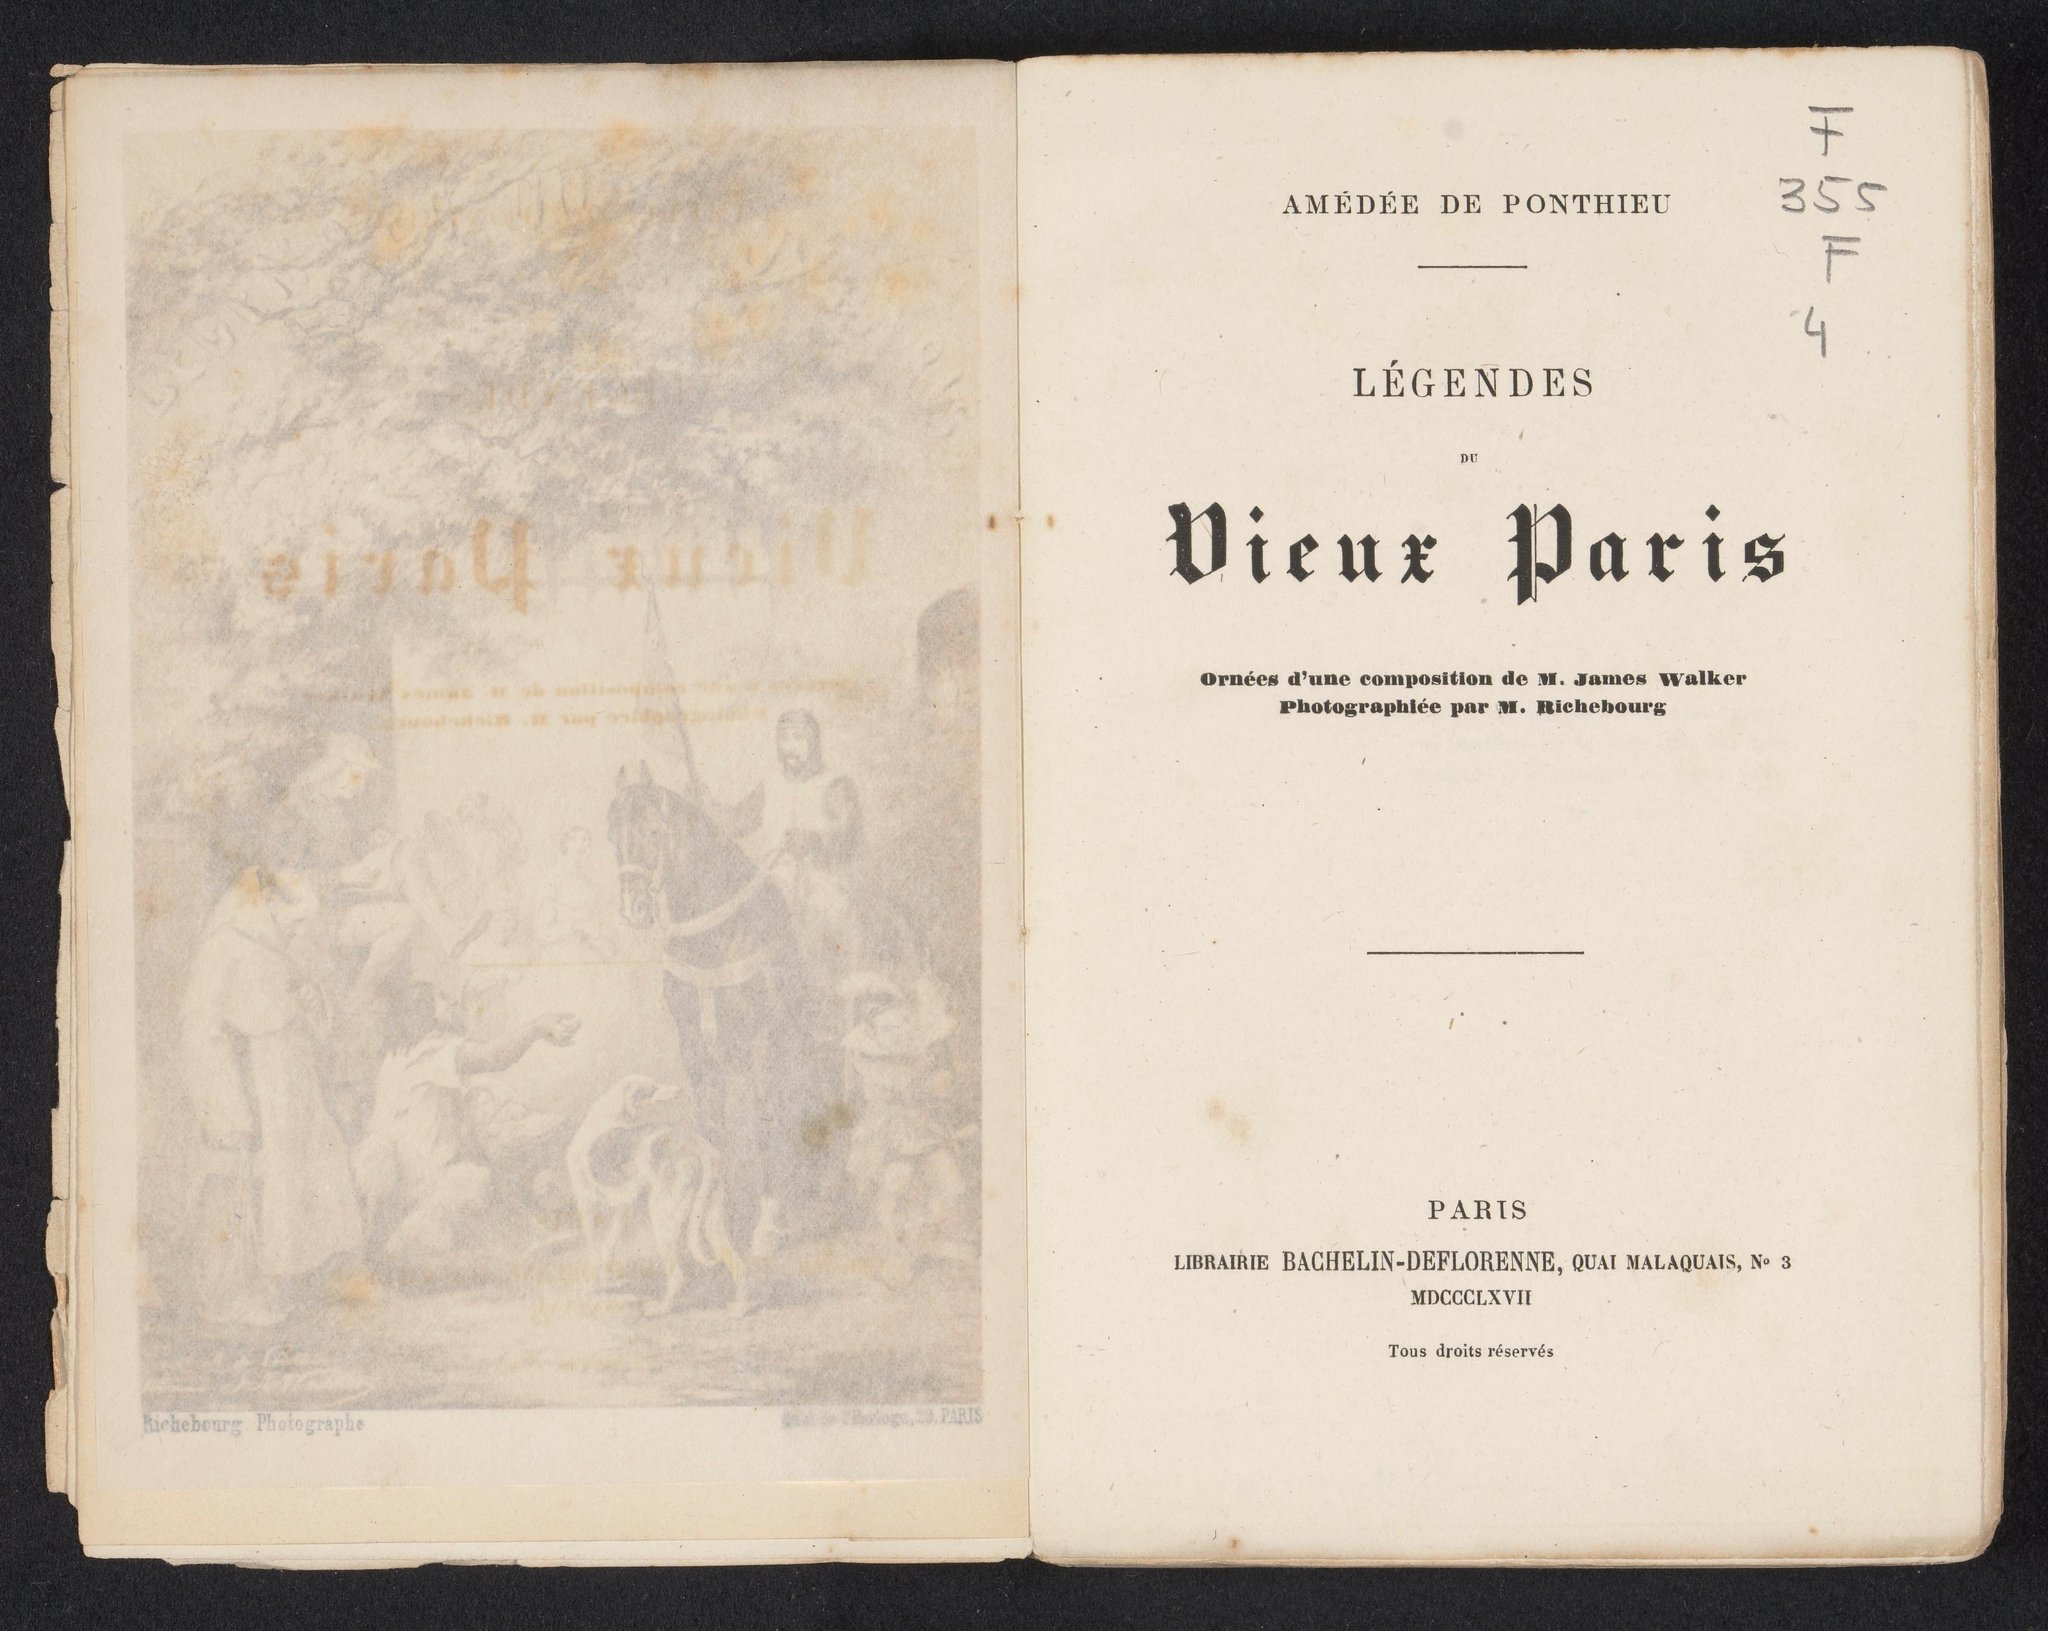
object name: book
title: Légendes du vieux Paris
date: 1867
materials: paper, photographic support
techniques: albumen print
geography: paris